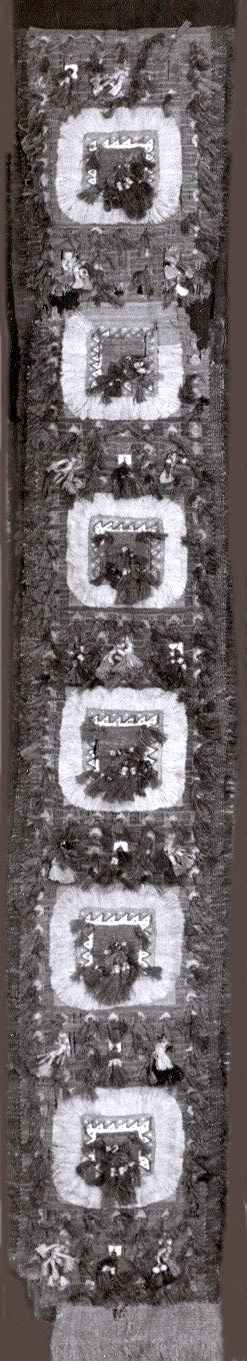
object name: turban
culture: chimú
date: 1101-1500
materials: animal fiber, cotton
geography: peru